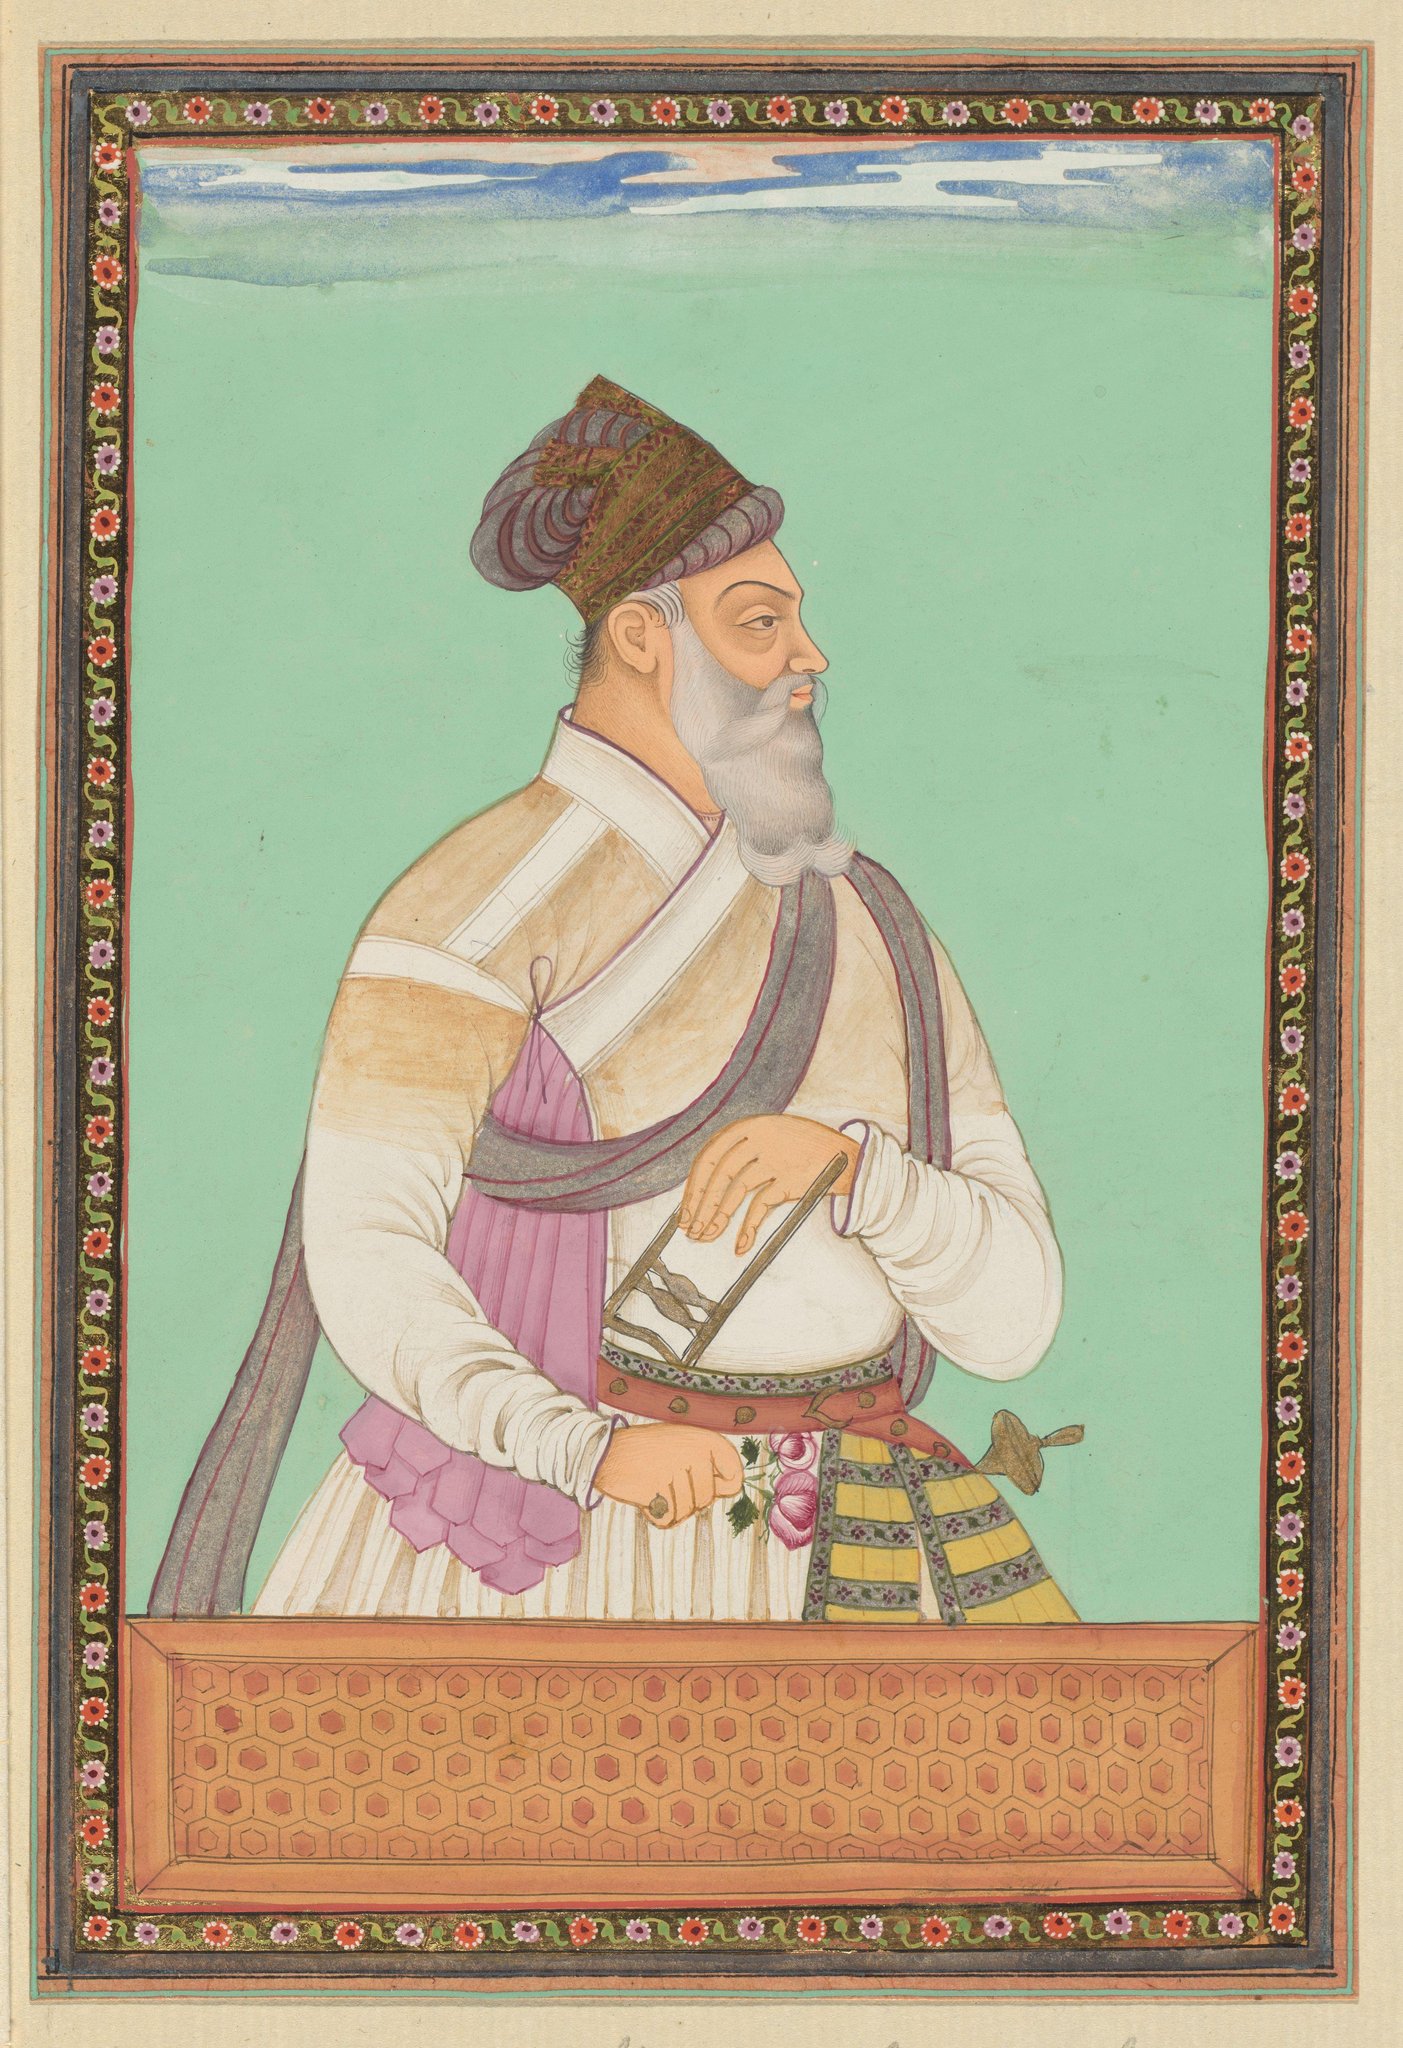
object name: indian miniature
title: Portret van Mirza Ilich Khan, die vizier van Aurangzeb is geweest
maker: Anonymous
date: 1686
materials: paint, gold leaf, gouache, paper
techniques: brush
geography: golkonda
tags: amsterdam, mayor, nicolaes cornelisz. witsen, historical person (...) - historical person (...) portrayed alone, ruler, sovereign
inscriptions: collector's mark: Lugt 1838, collector's mark: Lugt 240, annotation: ‘Mirsa Ailids-Chan Visir van Orangh Sieb’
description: Mirza Ilich Khan is tot aan zijn heupen afgebeeld, naar rechts gewend, in zijn rechter hand een bloem, zijn linker rust op een in zijn gordel gestoken kattan. Blad 15 in het `Witsen-Album', met 49 Indiase miniaturen van vorsten. Boven het portret een stukje papier met de naam in het Perzisch. Onder het portret een stukje papier met de naam in het Portugees.